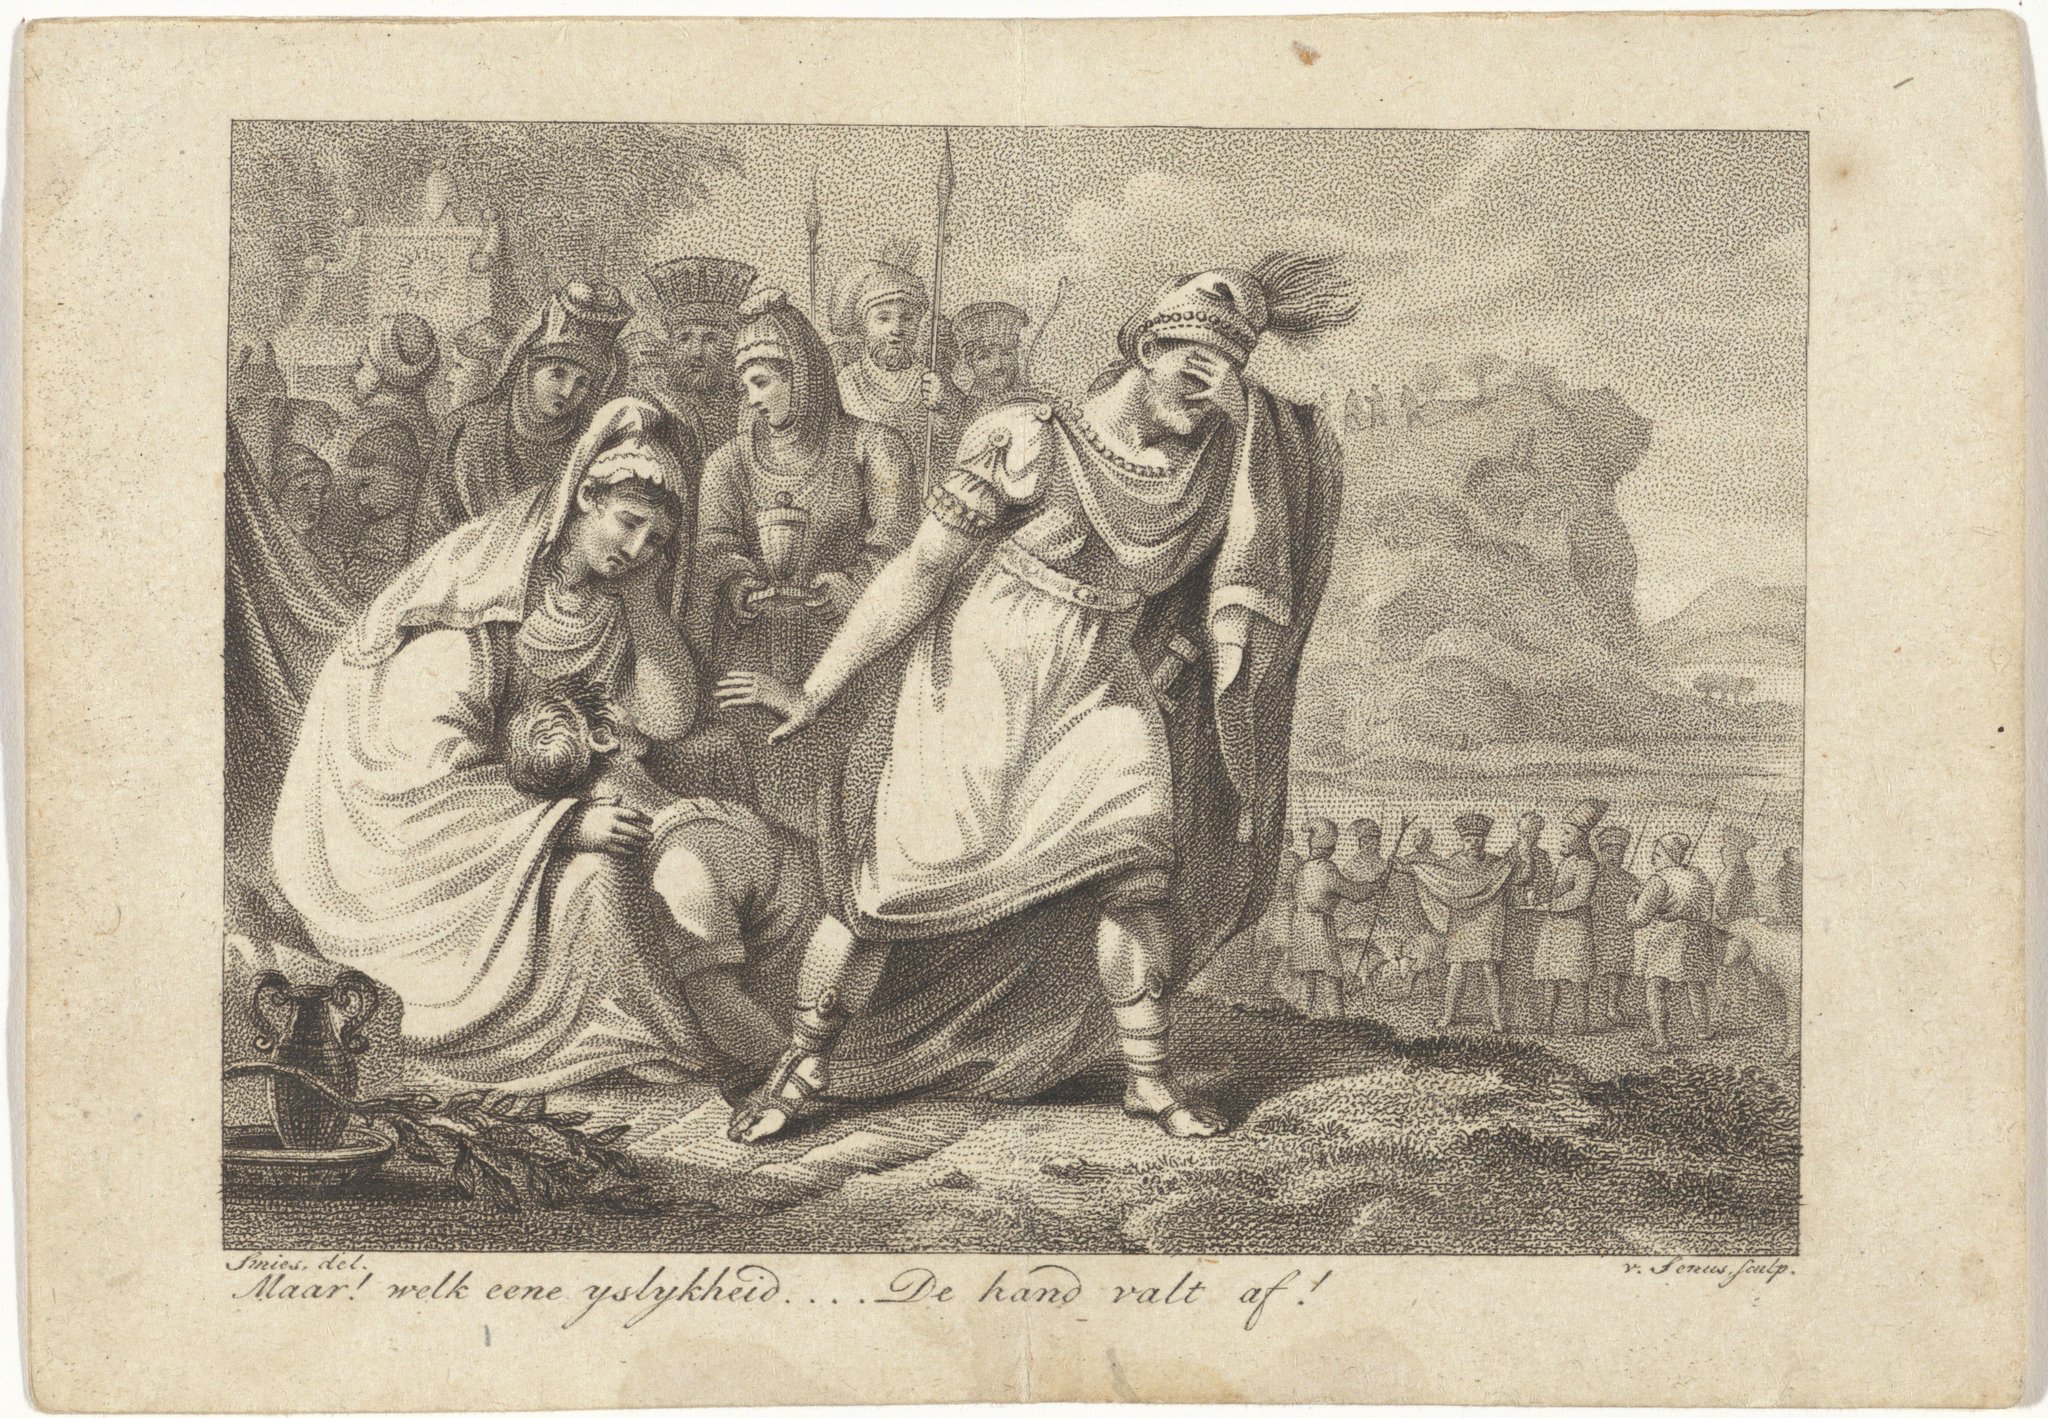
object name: print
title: Maar! welk een yslykheid (...)De hand valt af!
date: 1811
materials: paper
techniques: stippled etching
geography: netherlands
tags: medical aid and nursing of the sick and wounded on the battlefield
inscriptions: collector's mark: Lugt 2228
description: Een krijgsman wendt zich af van een groep treurende vrouwen, van wie de voorste geknield zit en een gewonde man in haar schoot heeft.